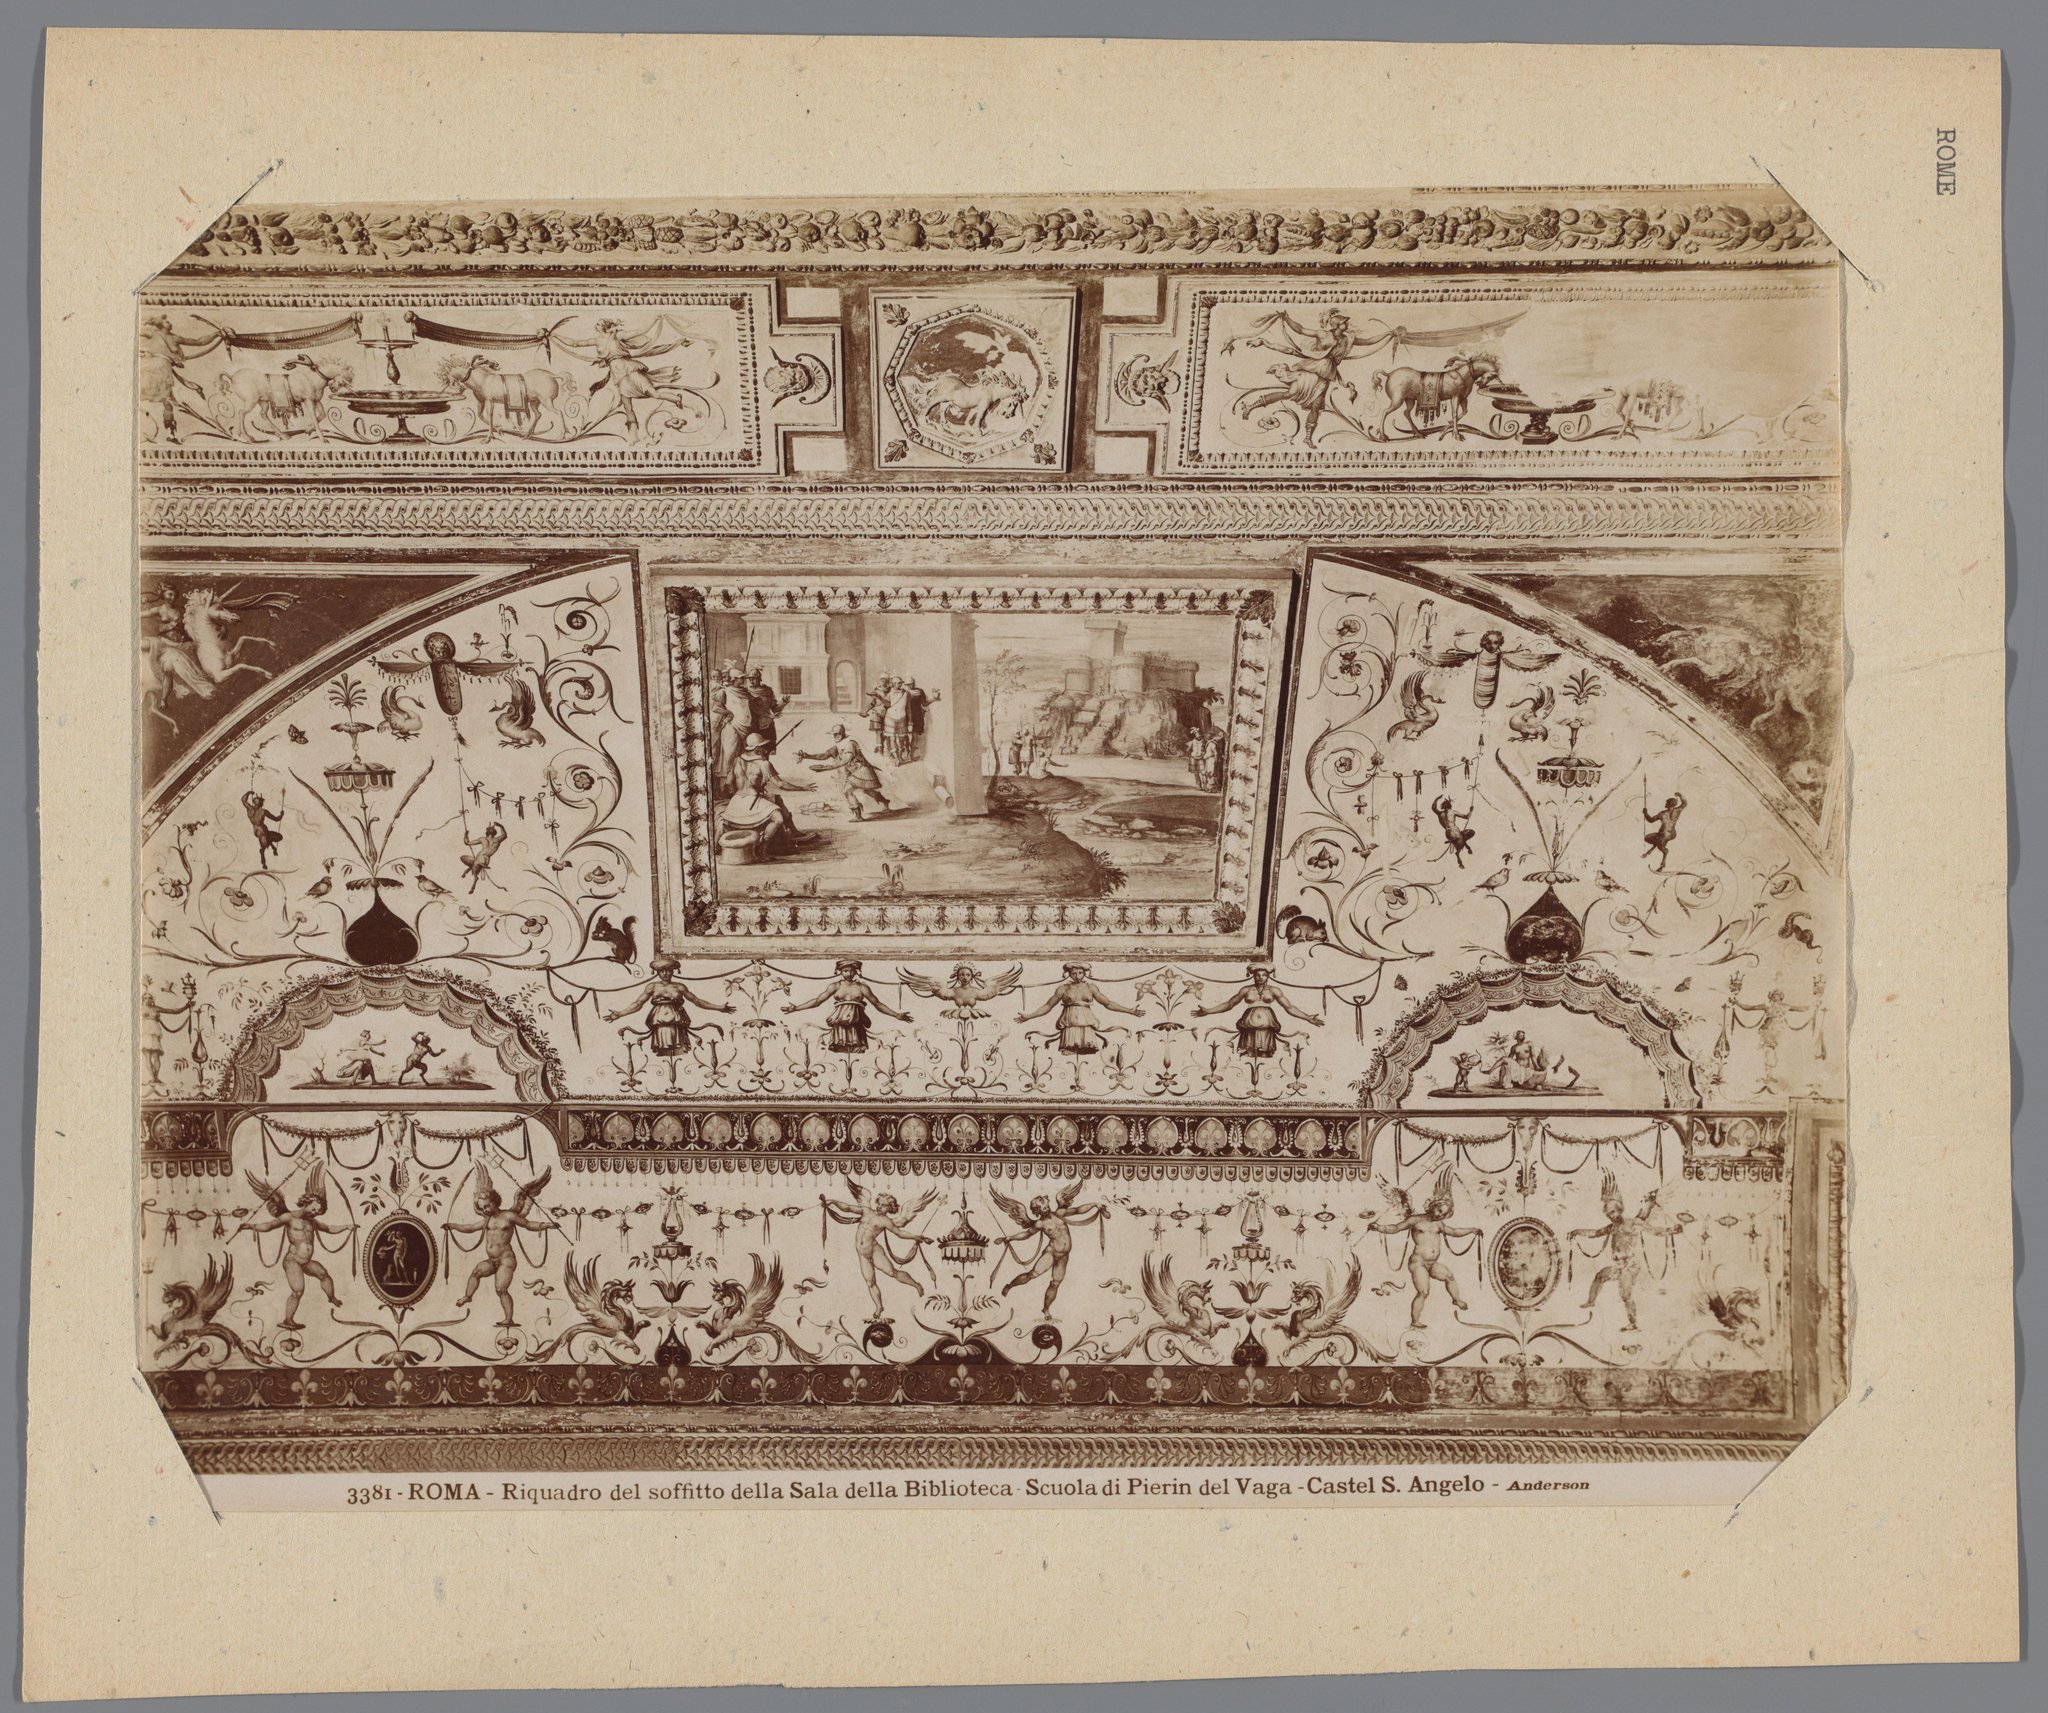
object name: photograph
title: Italië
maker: Anonymous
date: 1880-1910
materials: photographic support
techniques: albumen print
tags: italy